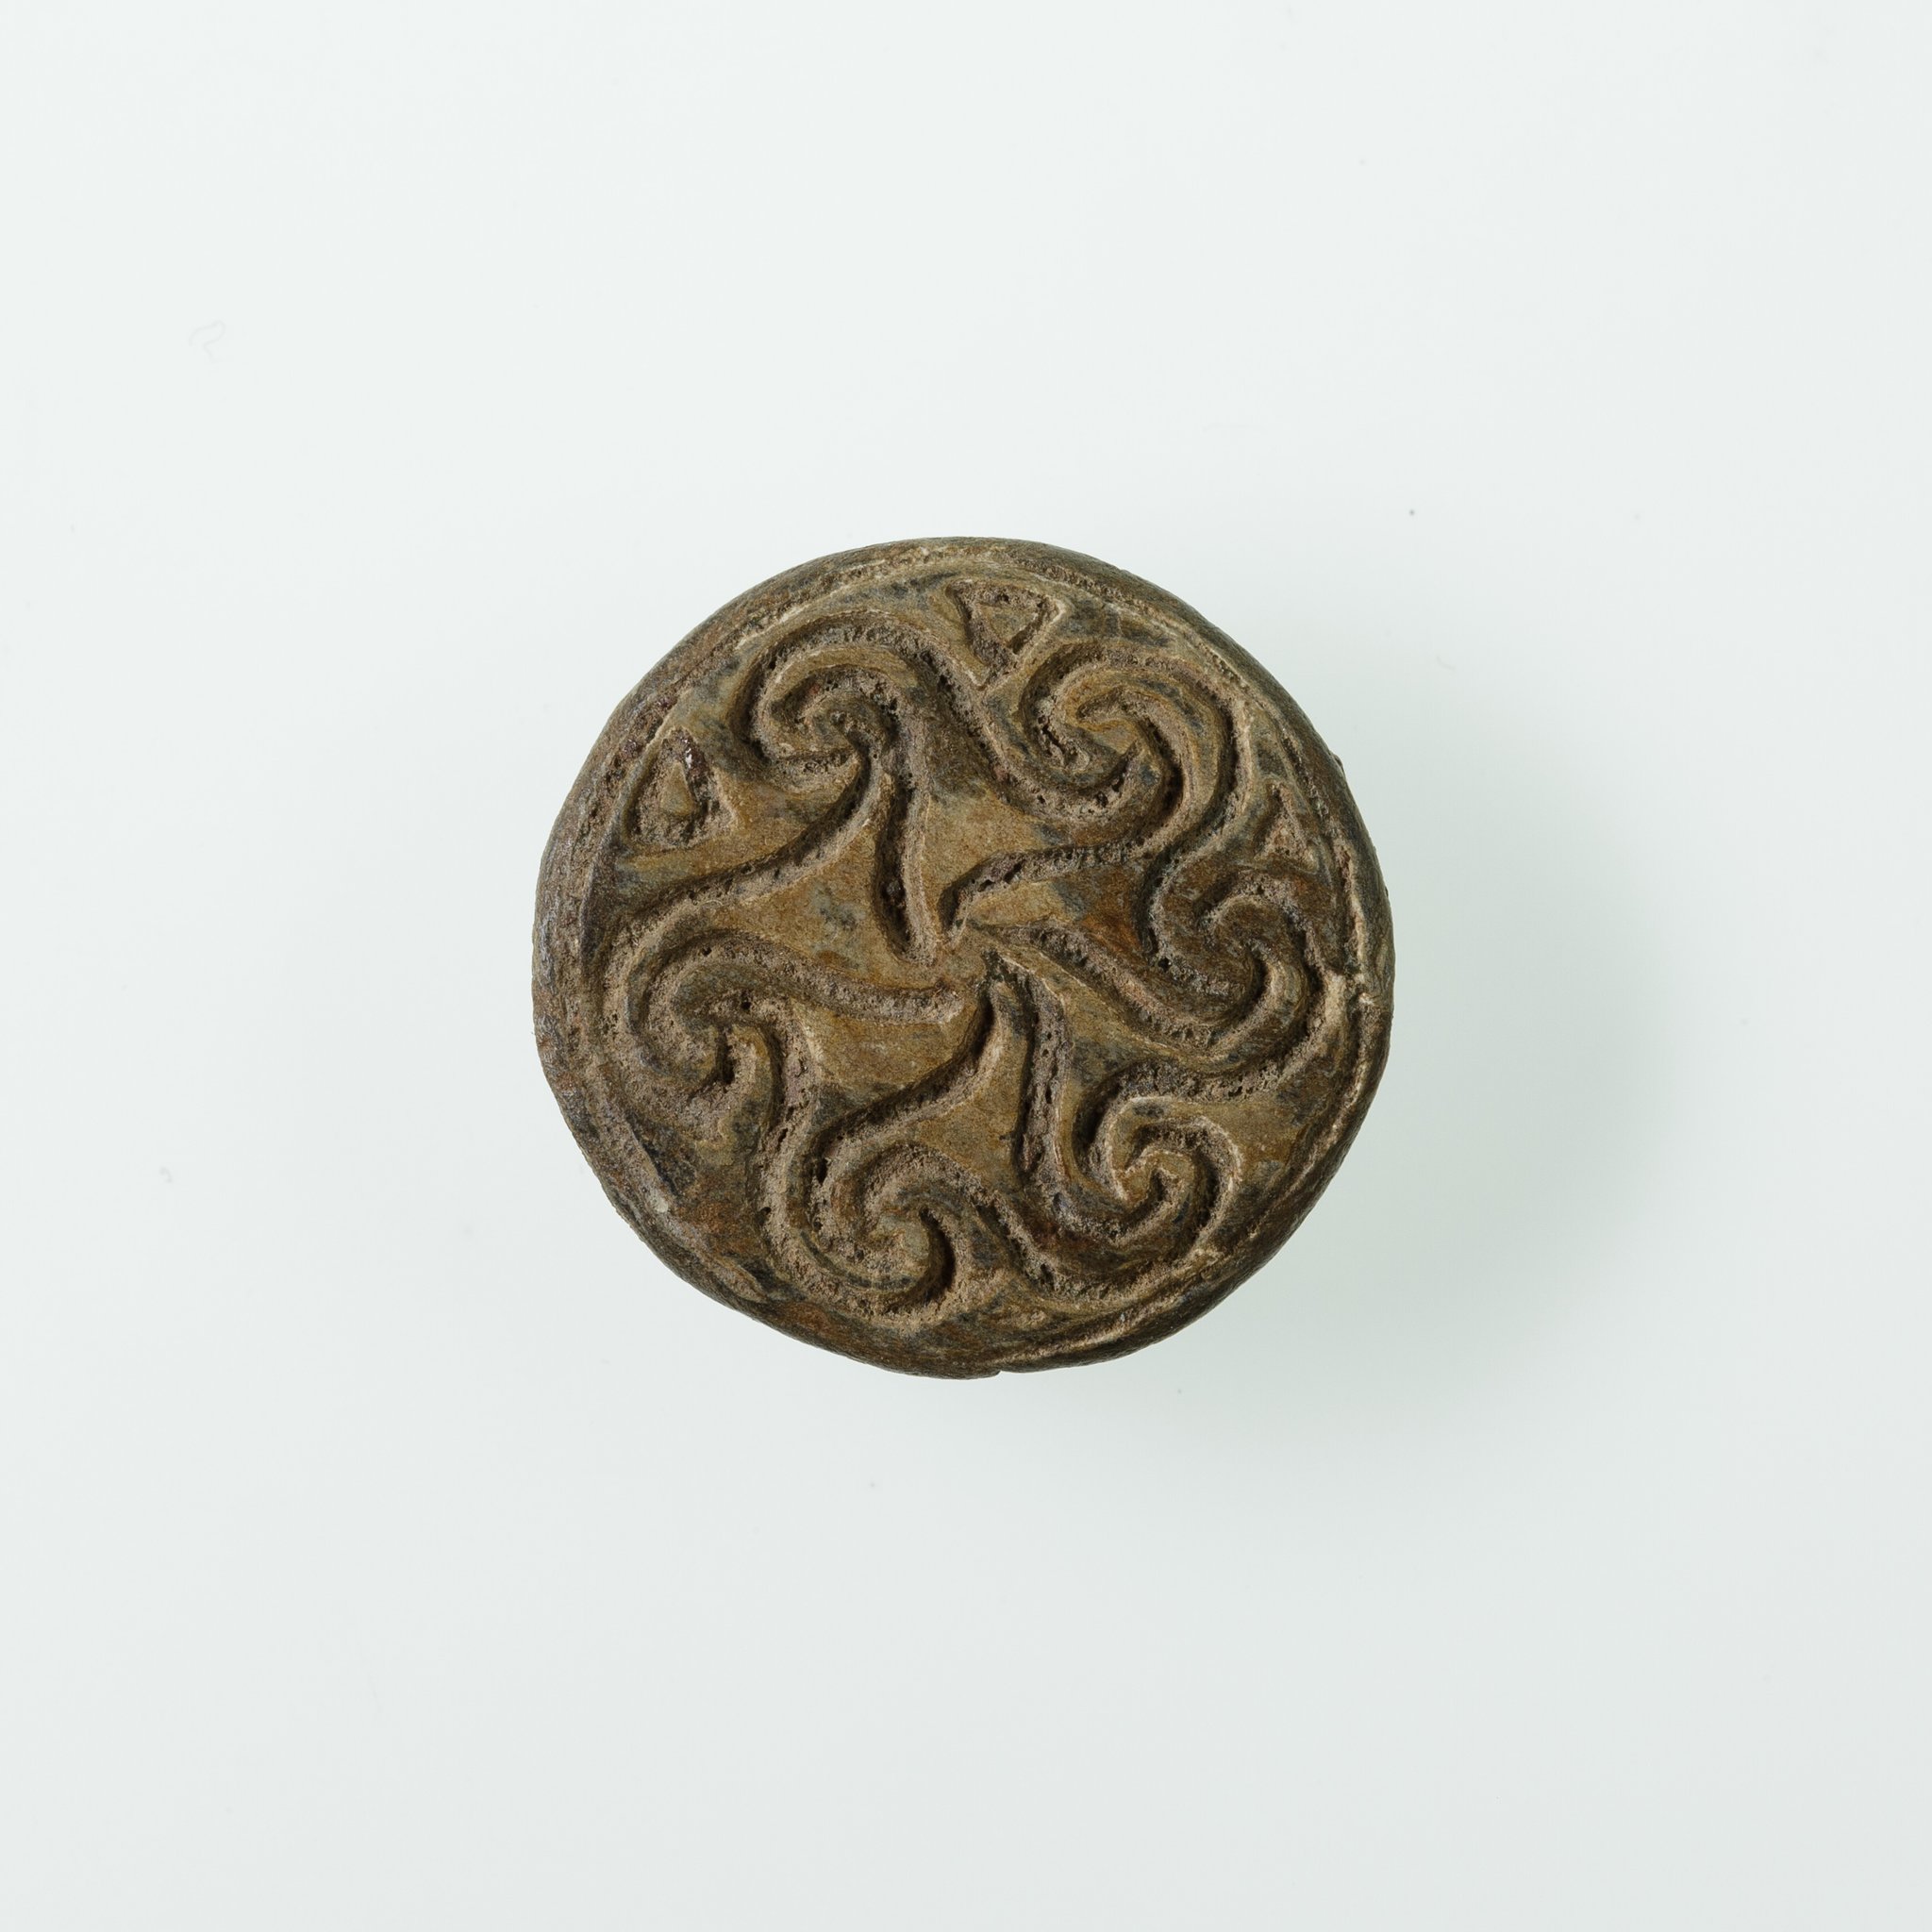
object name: seal, button, spiral, geometric design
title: Button Seal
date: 2030-1850 BCE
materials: stone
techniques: glazing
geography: egypt